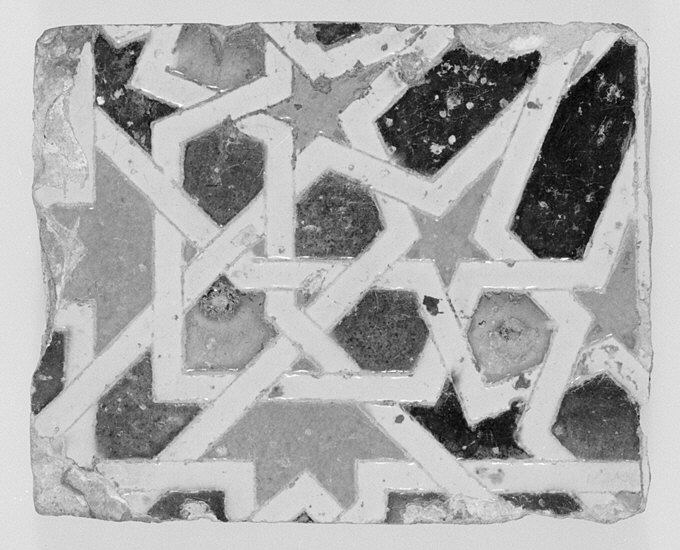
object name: panel fragment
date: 1501-1600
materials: earthenware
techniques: glazing